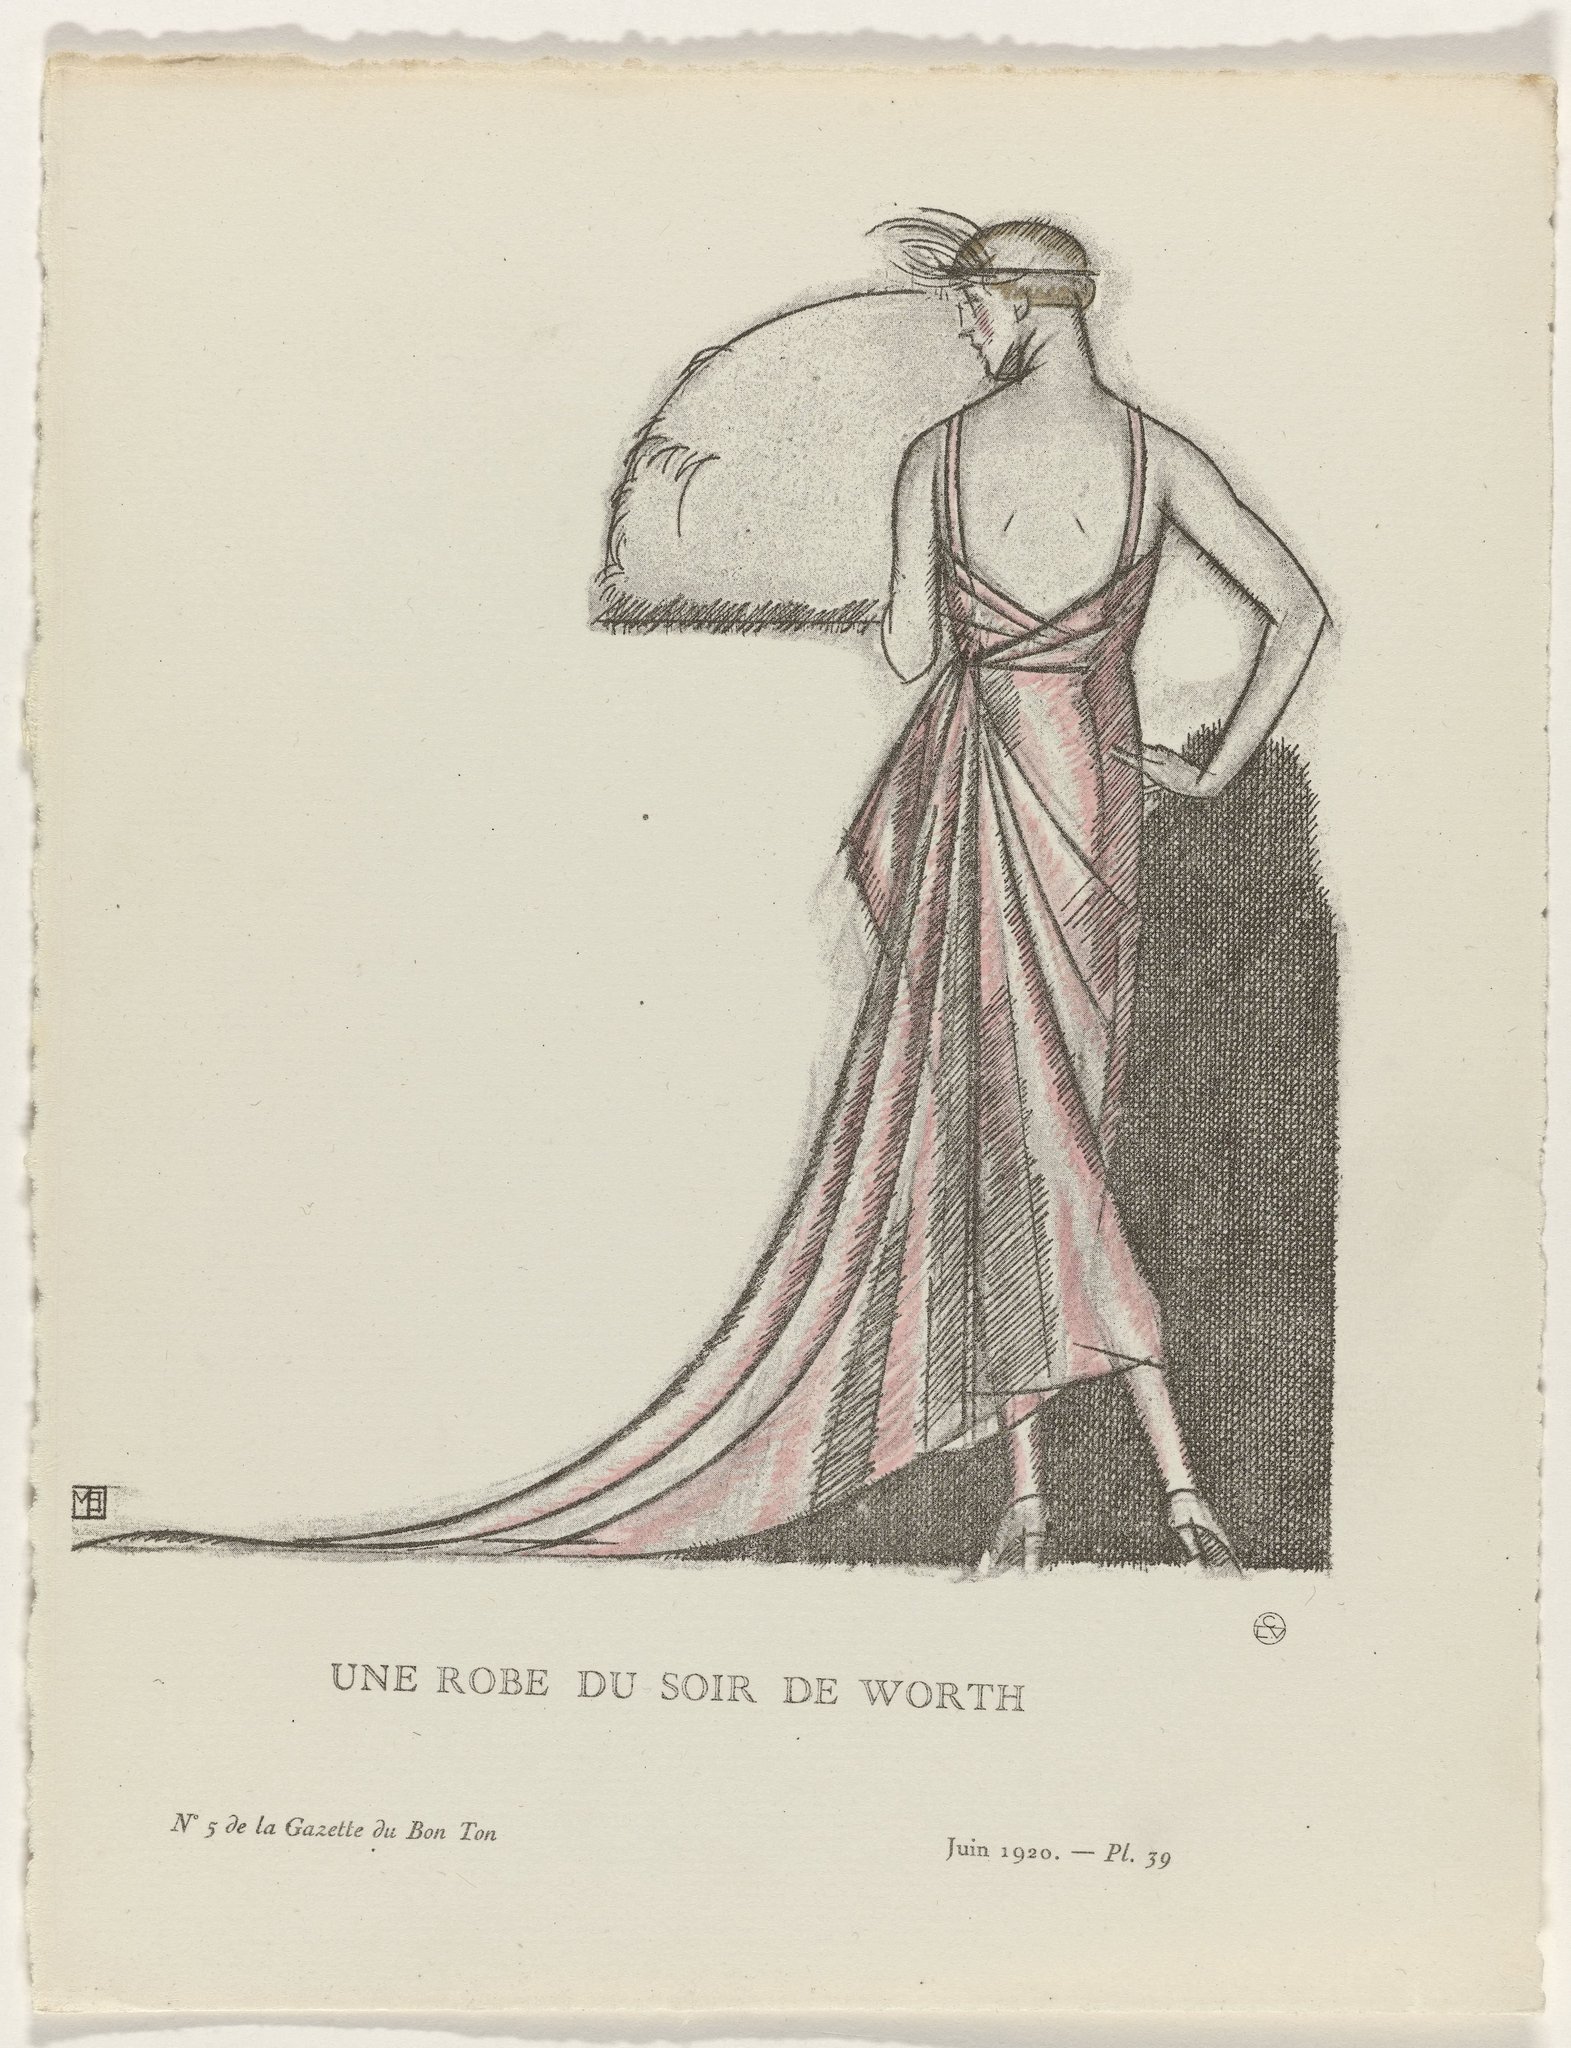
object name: fashion print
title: Gazette du Bon Ton, 1920 - No. 5 : Une robe du soir de Worth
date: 1920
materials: paper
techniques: hand coloring, letterpress printing, photochemical processes, pochoir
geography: geneva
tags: dress, gown: evening dress (+ women's clothes), head-gear (+ women's clothes), fashion plates, shoes, sandals (+ women's clothes), fan (+ women's clothes)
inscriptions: date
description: Staande vrouw, op de rug gezien, gekleed in een avondjapon met sleep van Worth. In de linkerhand een grote waaier. Planche 39 uit Gazette du Bon Ton 1920, No. 5. Uitleg over de kleding op pagina "Explication des Planches".